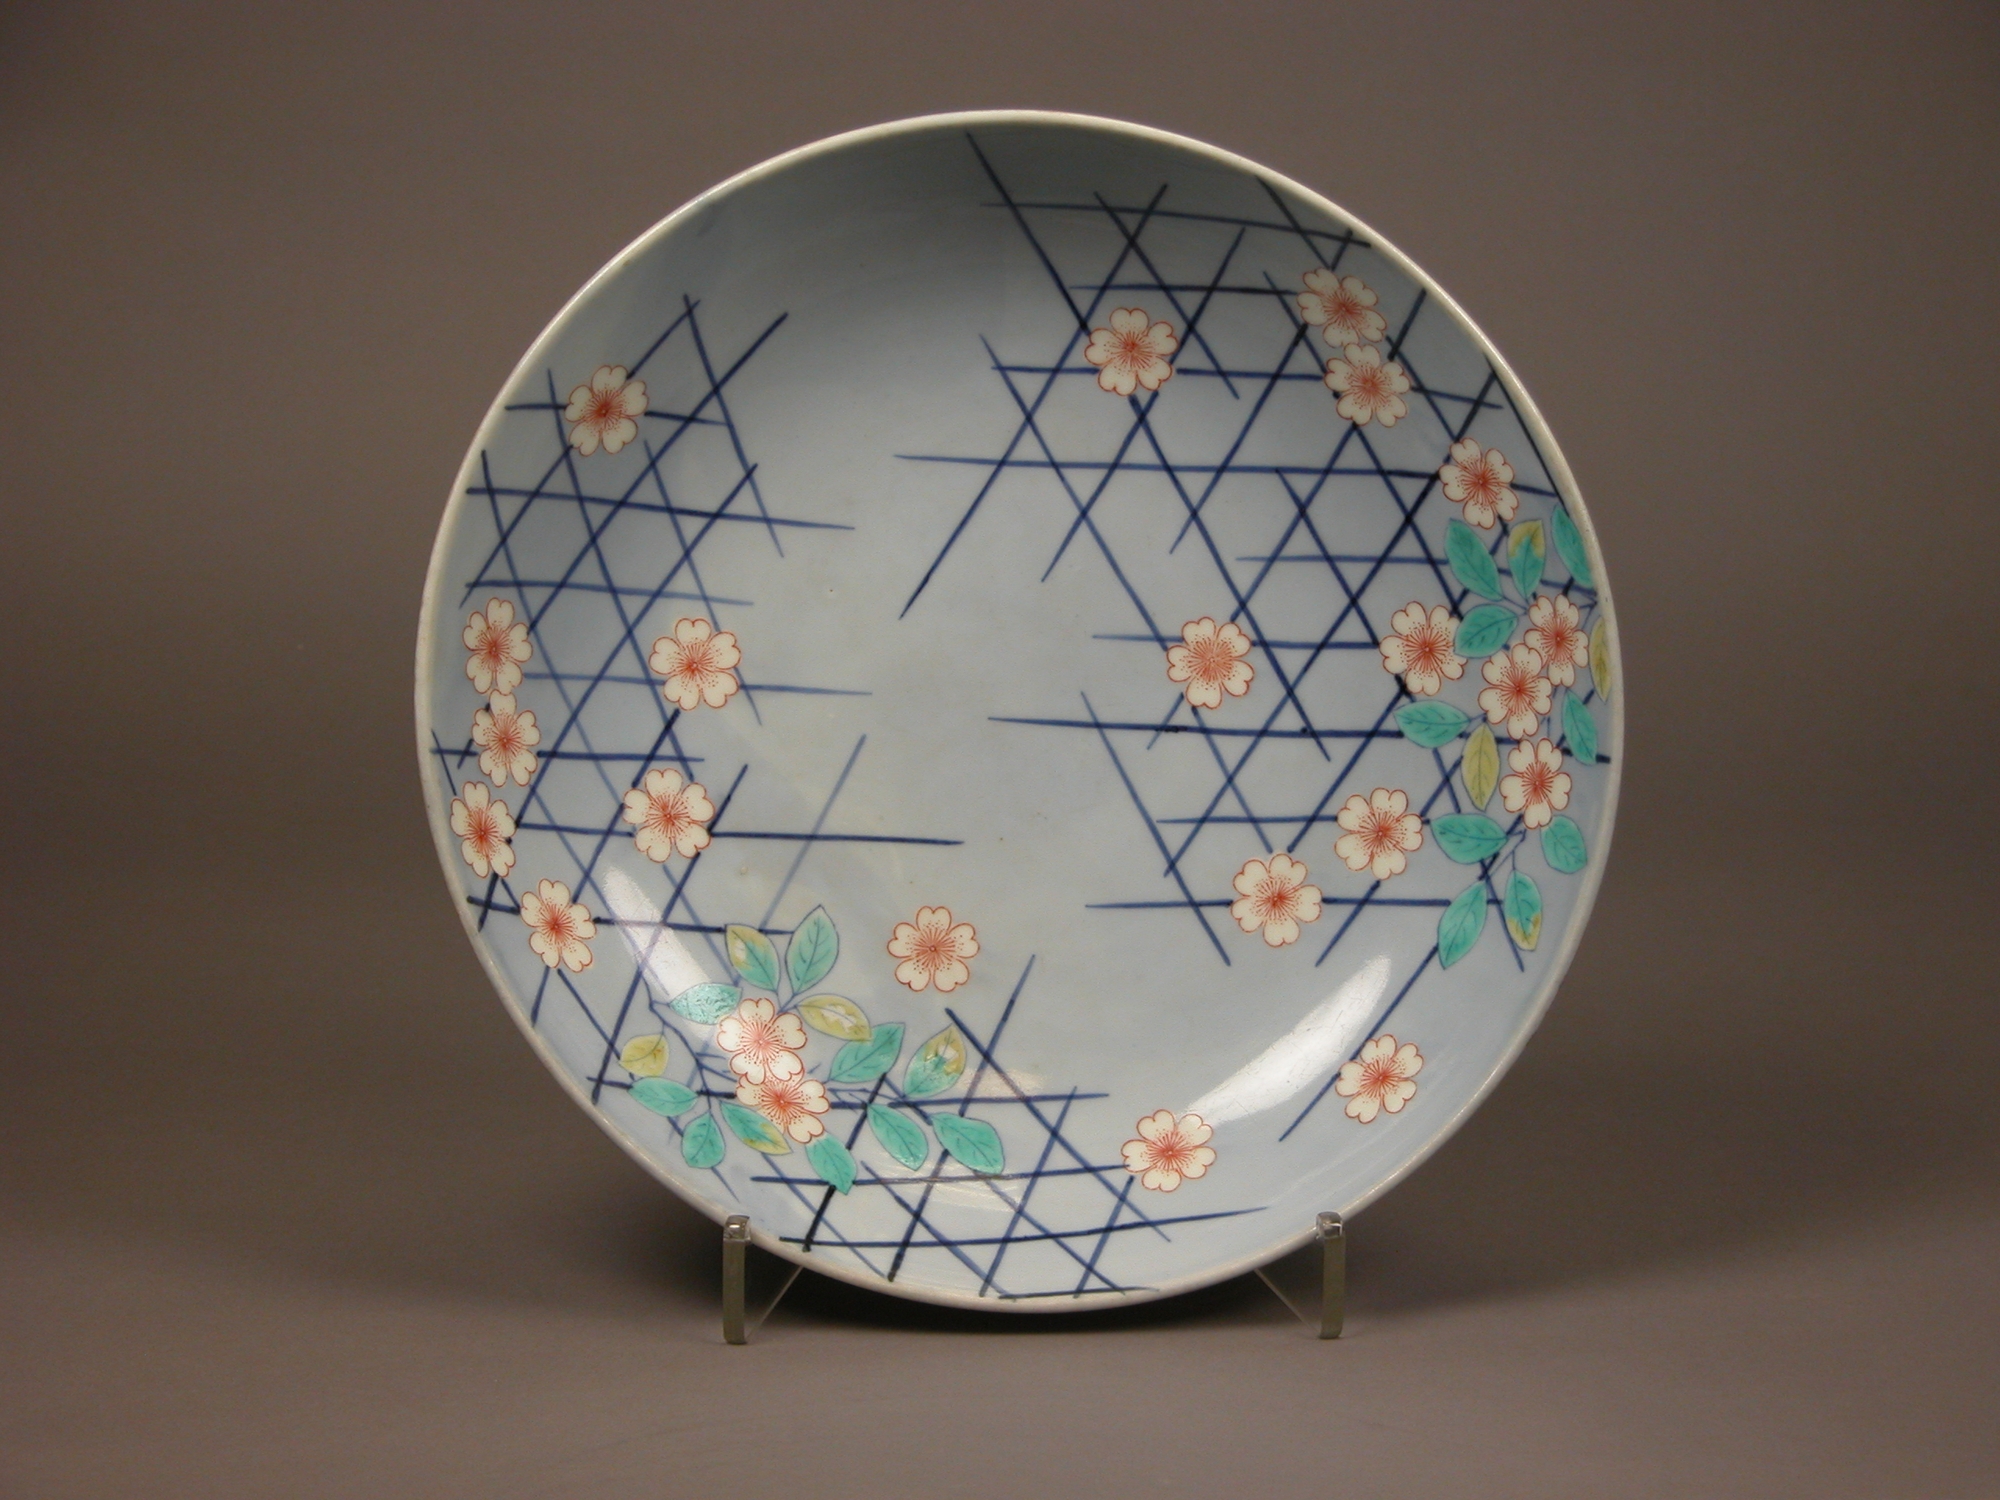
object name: dish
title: Large Dish with Cherry Blossoms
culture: japanese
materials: enamel, porcelain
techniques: overglaze, painting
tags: flowers,leaves